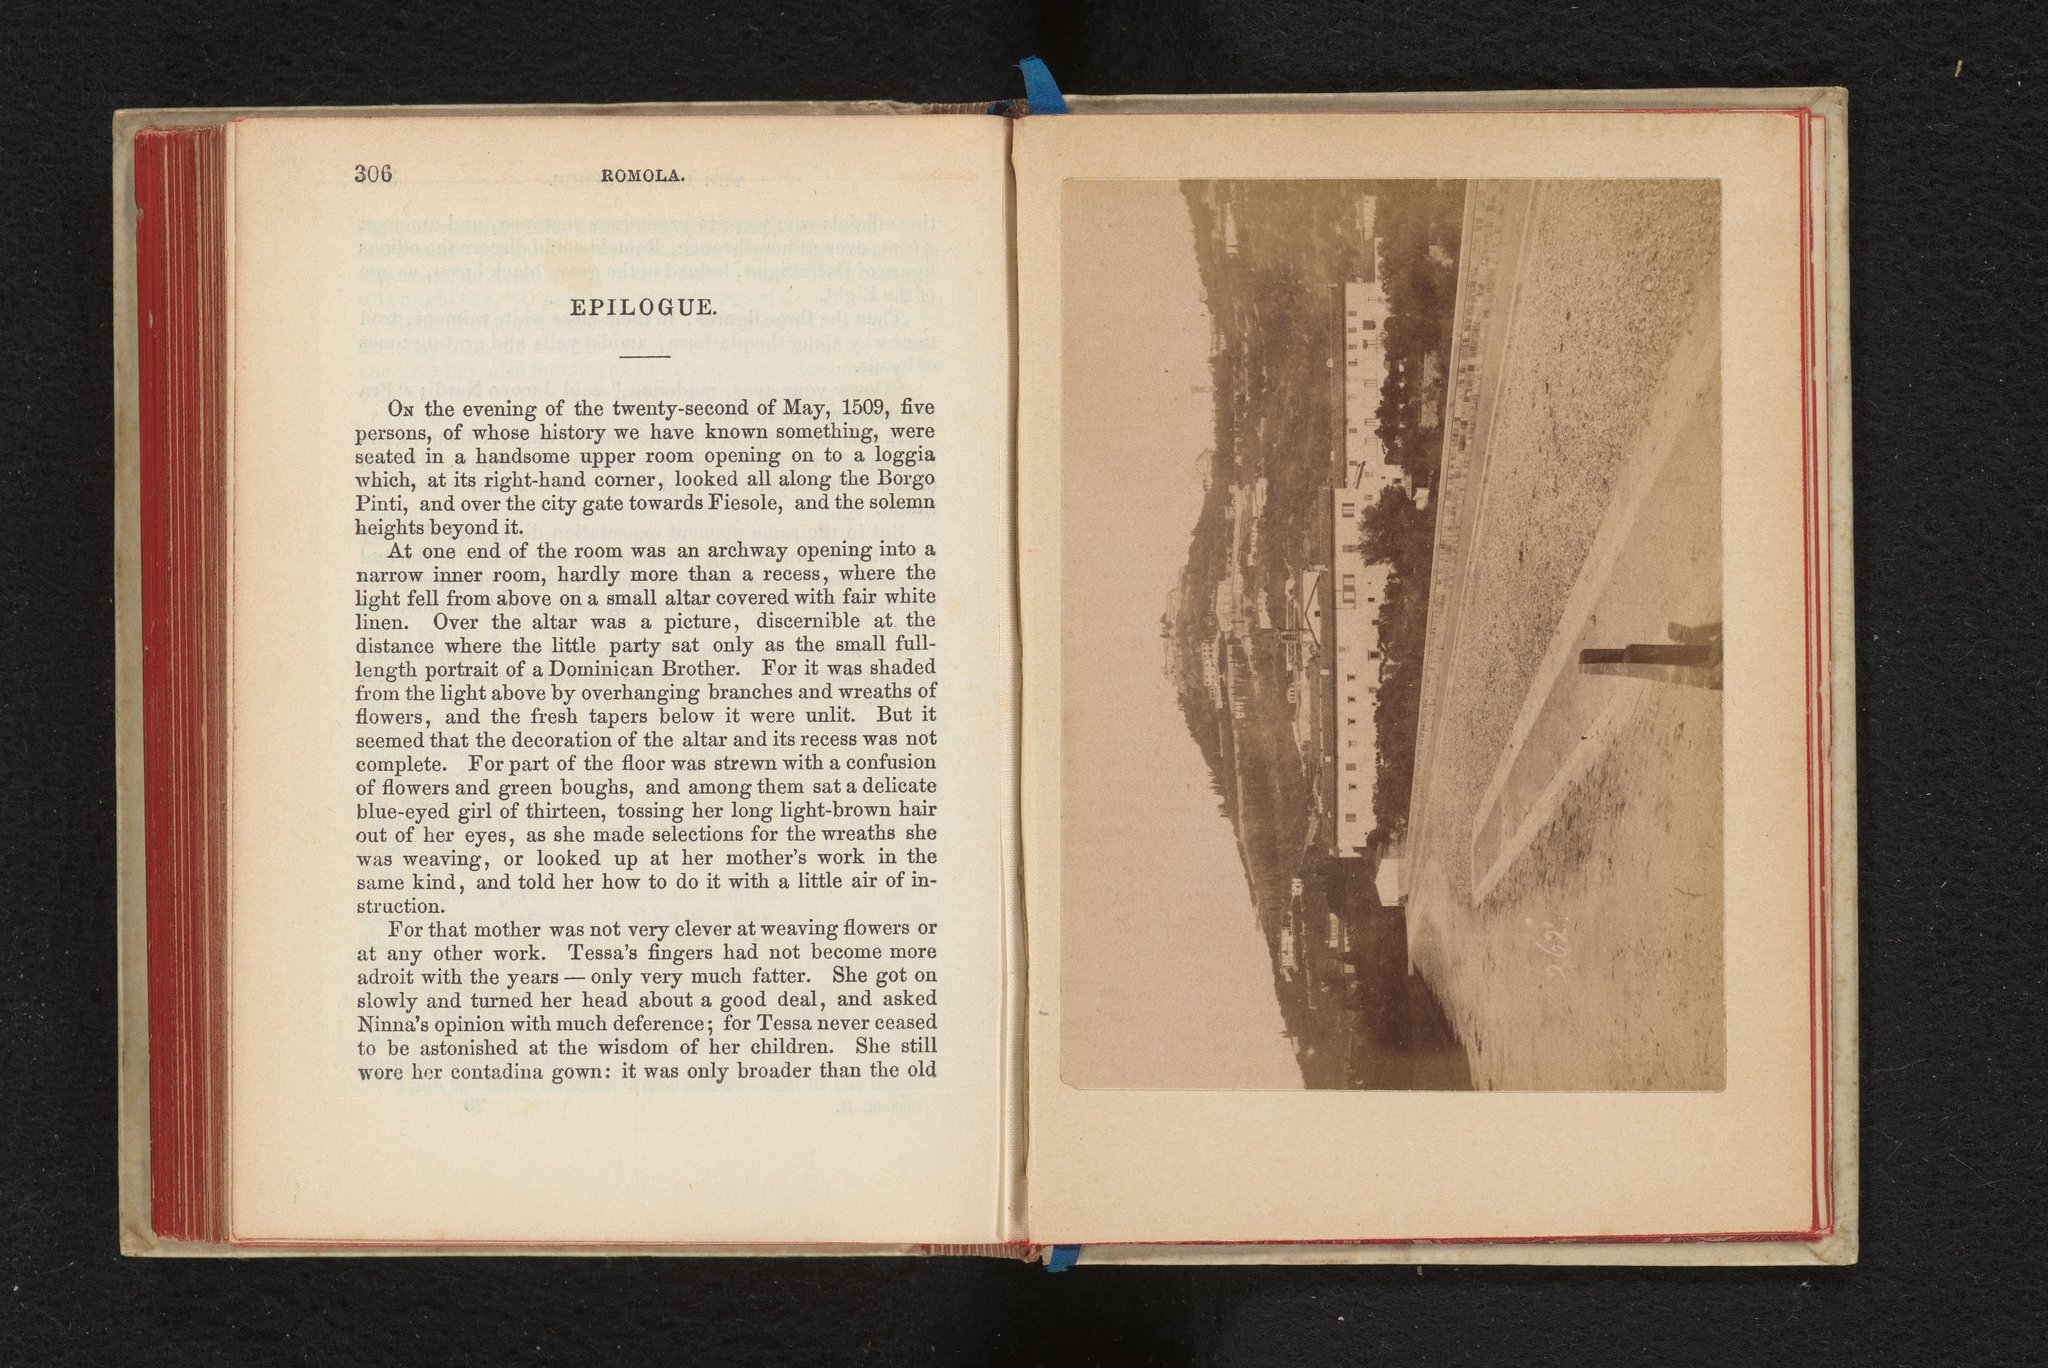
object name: page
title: Gezicht op Fiesole, gezien vanuit Florence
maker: giacomo brogi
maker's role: fotograaf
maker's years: 1822-1881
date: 1858-1863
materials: paper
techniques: albumen print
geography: florence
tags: prospect of village, silhouette of village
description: Foto op ongenummerde pagina tegenover pagina 306.